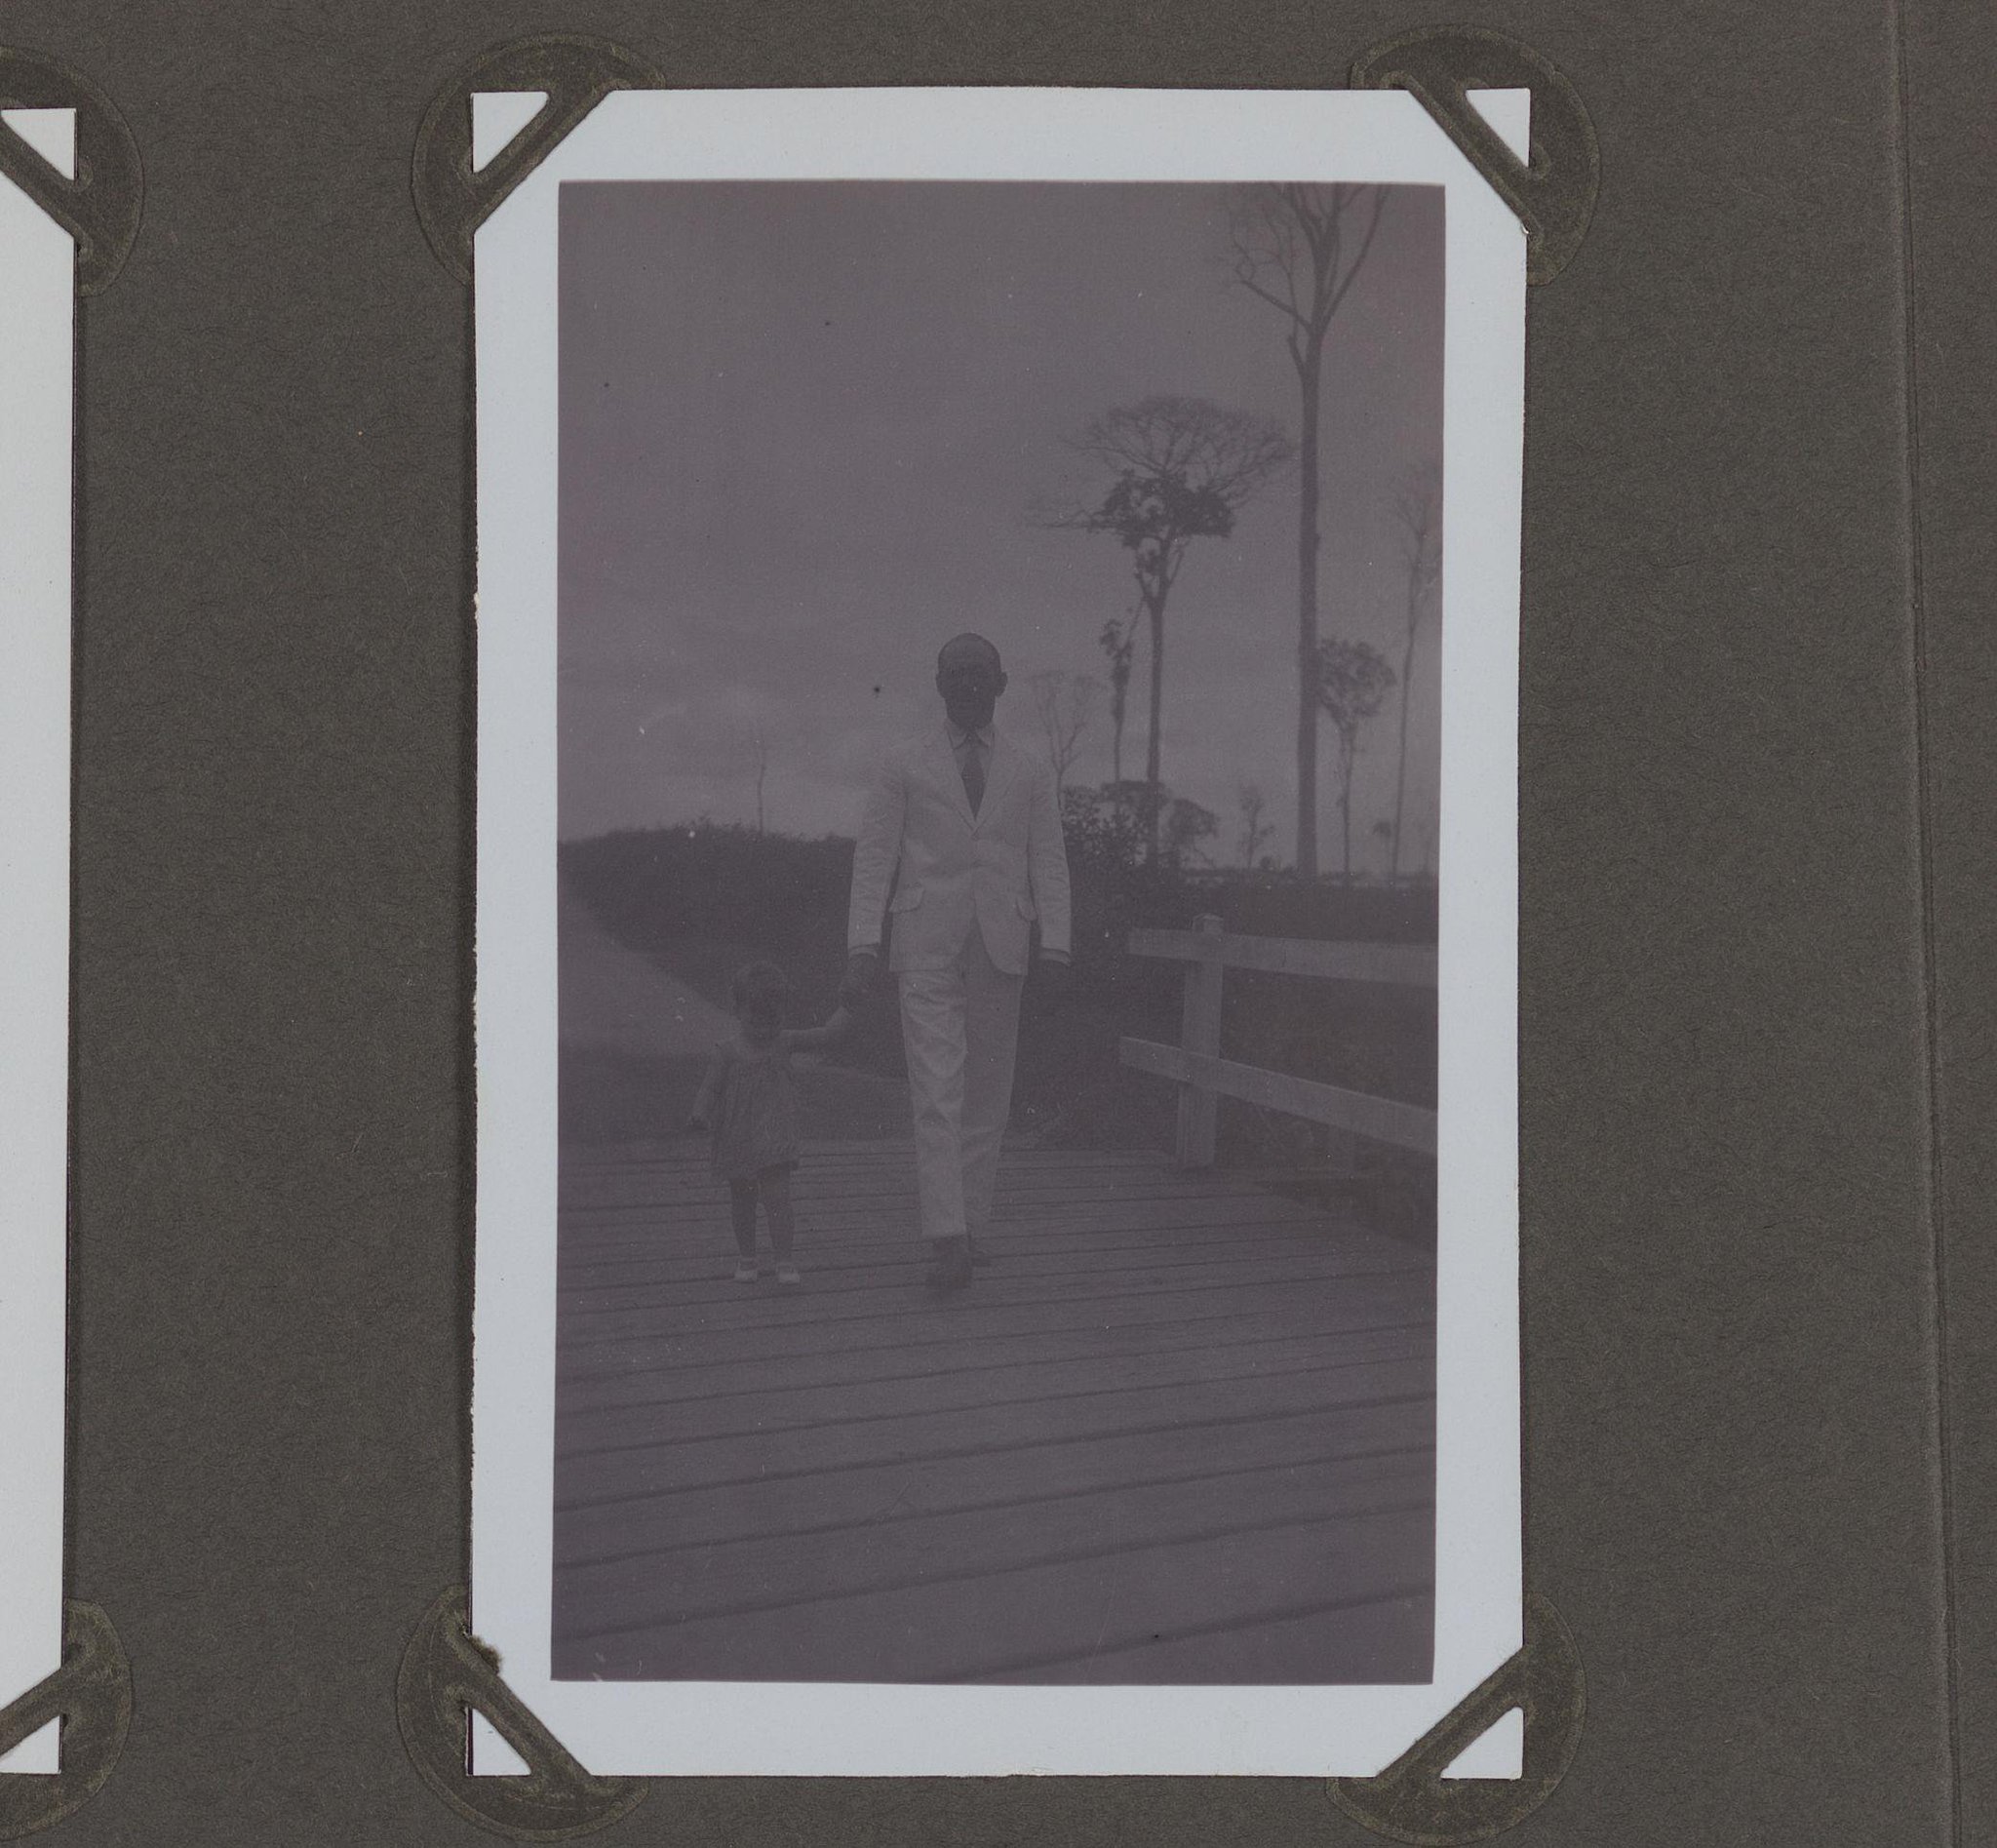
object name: photograph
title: Familiefoto van het gezin Jetten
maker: Anonymous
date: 1925-1927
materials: photographic support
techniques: photography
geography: suriname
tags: jetten, familie, moengo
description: Familiefoto van de kinderen Jetten in Suriname. Foto op een bladzijde van een los albumblad. Onderdeel van het ensemble met foto's van de familie van ingenieur Jetten in de mijnbouwstad Moengo in Suriname.